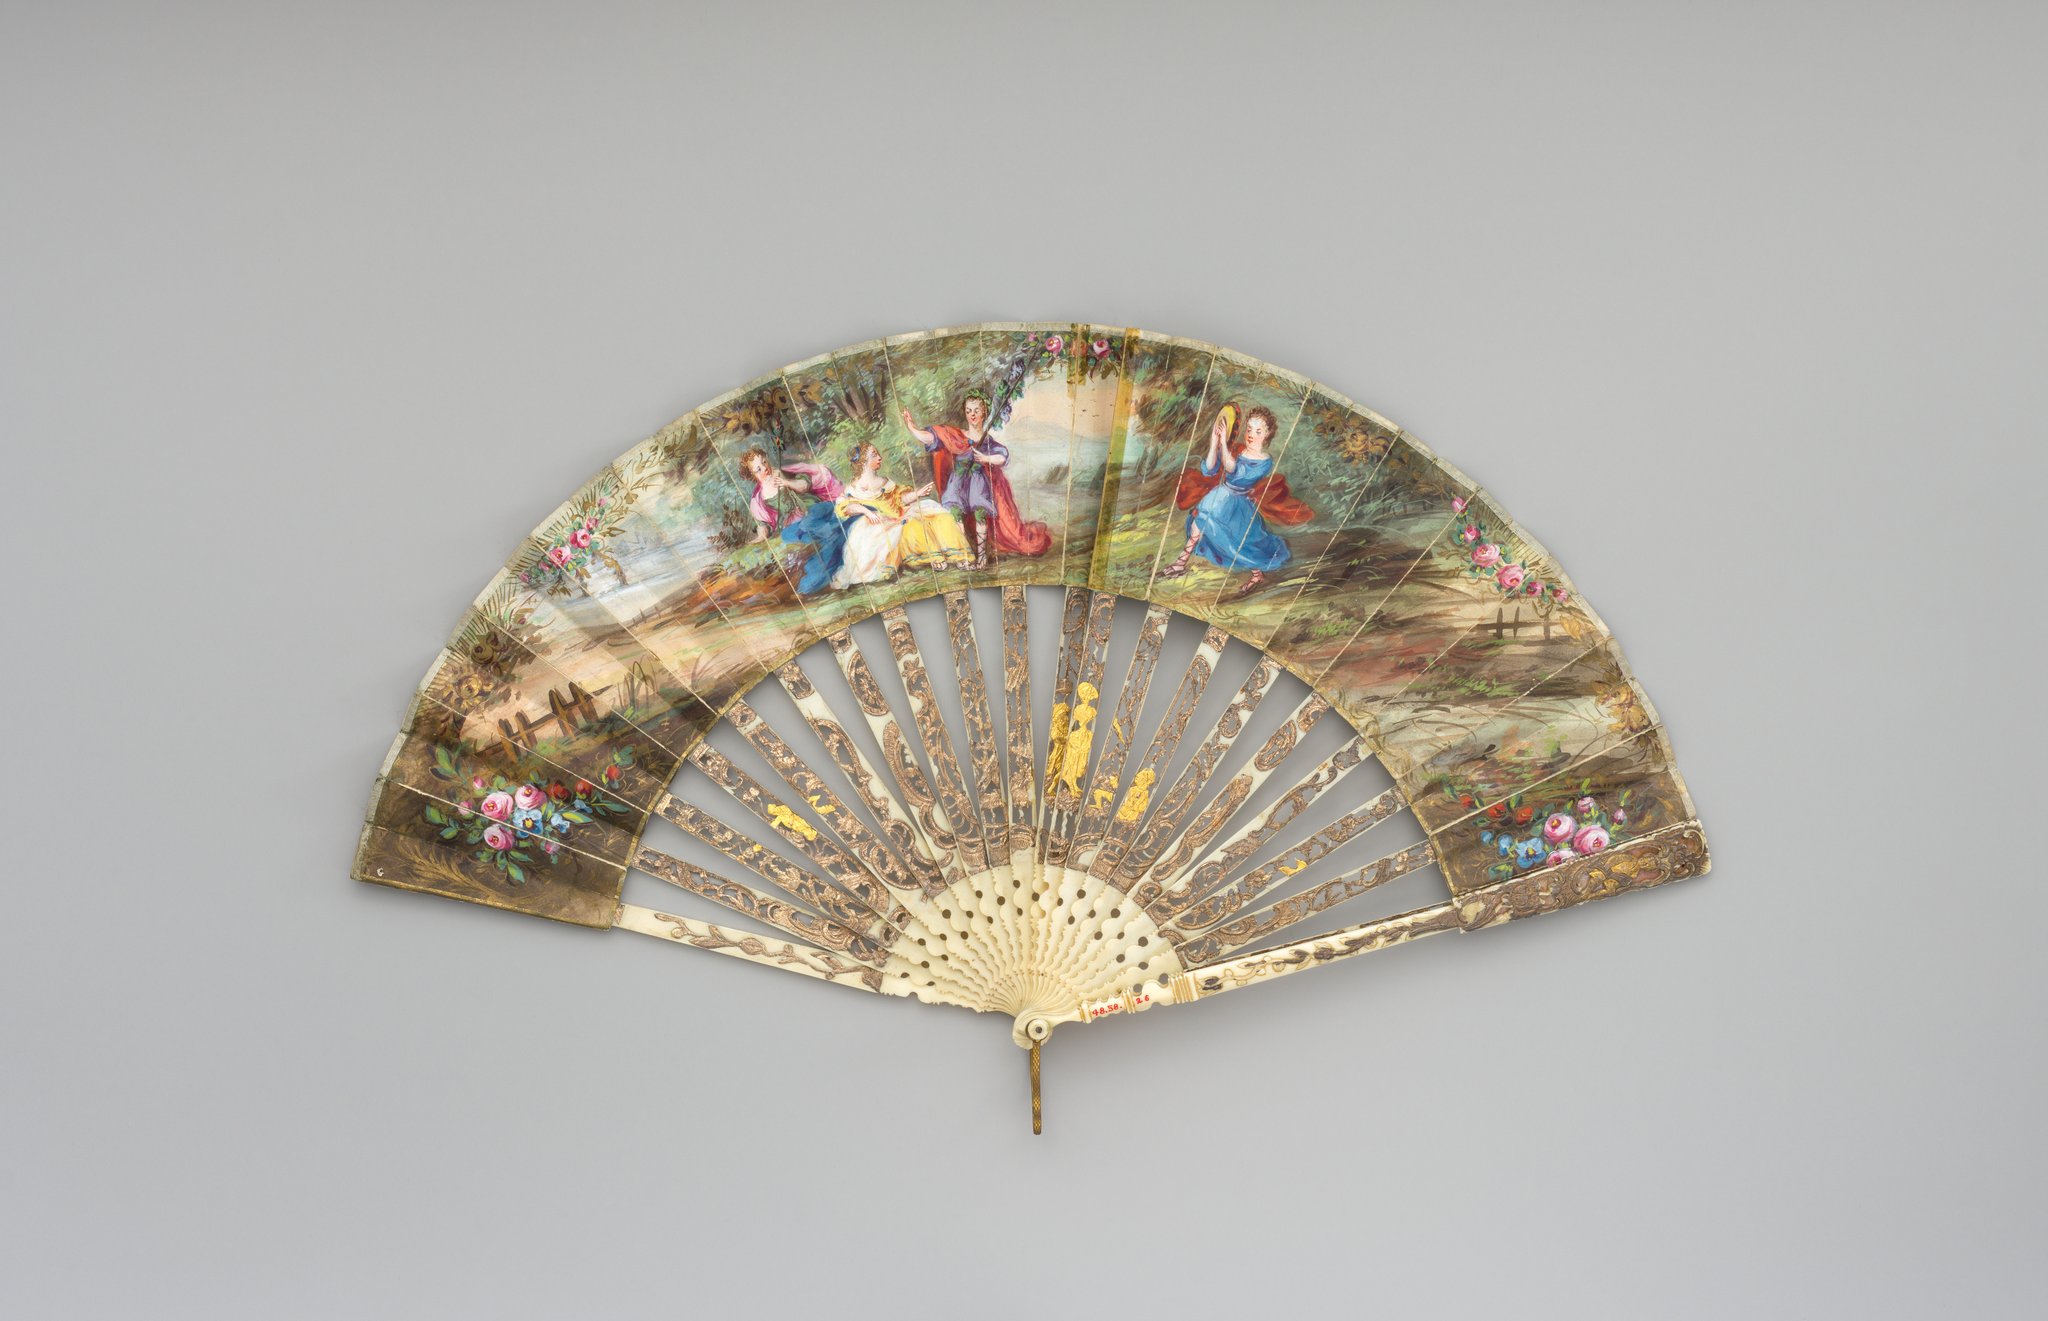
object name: fan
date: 1863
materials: gilt, ivory, metal, paint, parchment, textile, silver gilt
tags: women